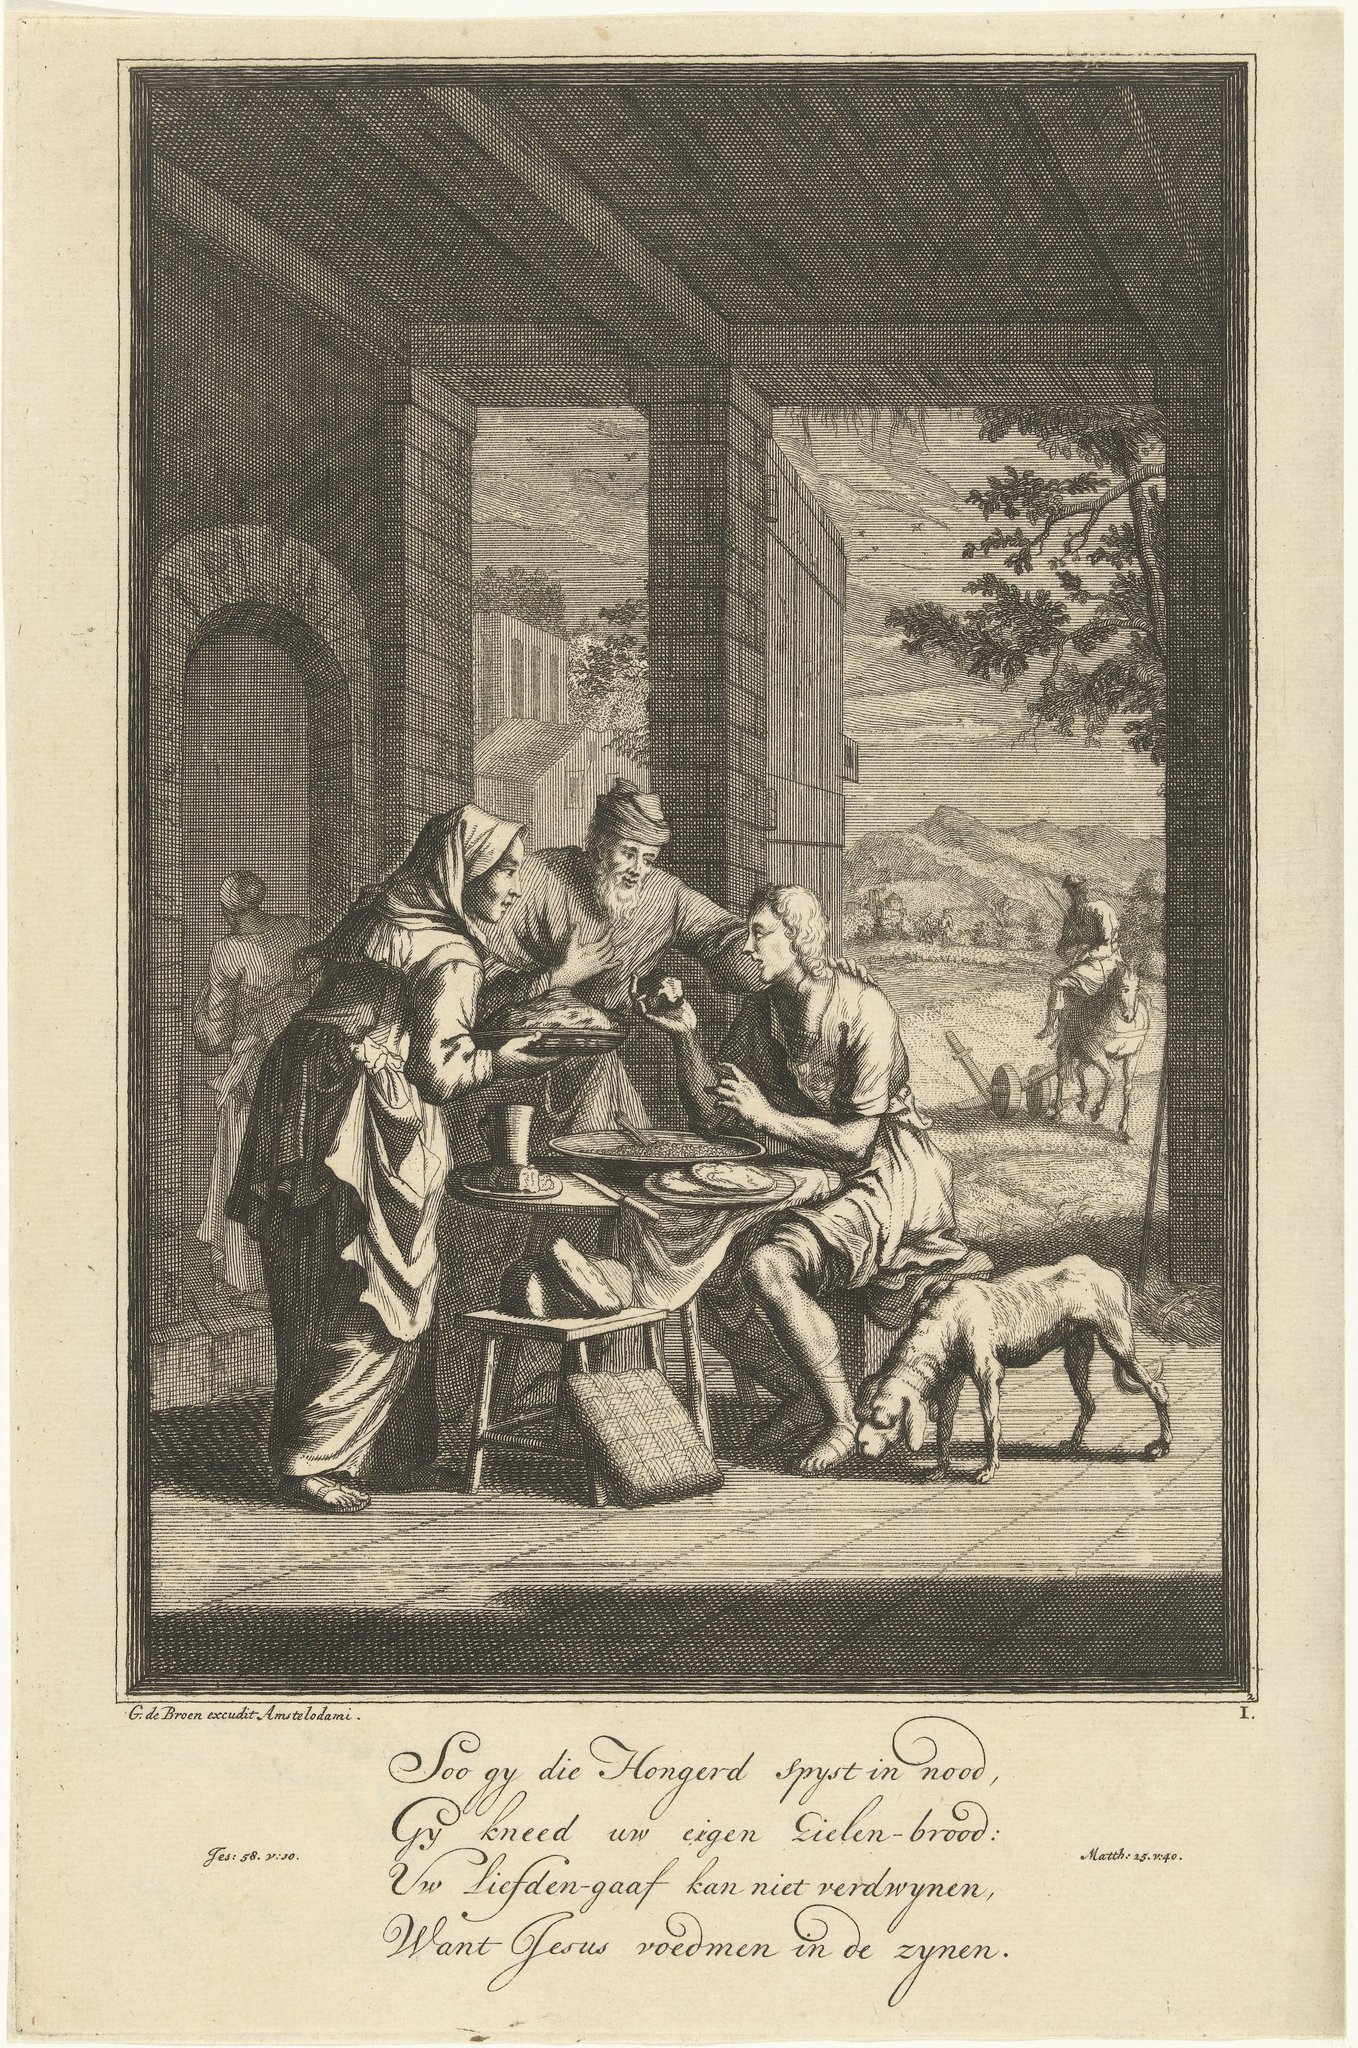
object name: print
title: Zeven werken van barmhartigheid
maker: gerrit de broen (i)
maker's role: print maker, publisher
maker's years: 1659-1740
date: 1695-1740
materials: paper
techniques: engraving, etching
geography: amsterdam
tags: feeding the hungry, 'esuriens cibatur' ~ one of the (seven) acts of mercy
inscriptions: collector's mark: Lugt 2228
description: Een echtpaar verwelkomt een hongerige reiziger in hun huis en geeft hem te eten. Door de openstaande deur is een boer die op het land werkt te zien. Onder de voorstelling een Nederlands vers over de werken van barmhartigheid.